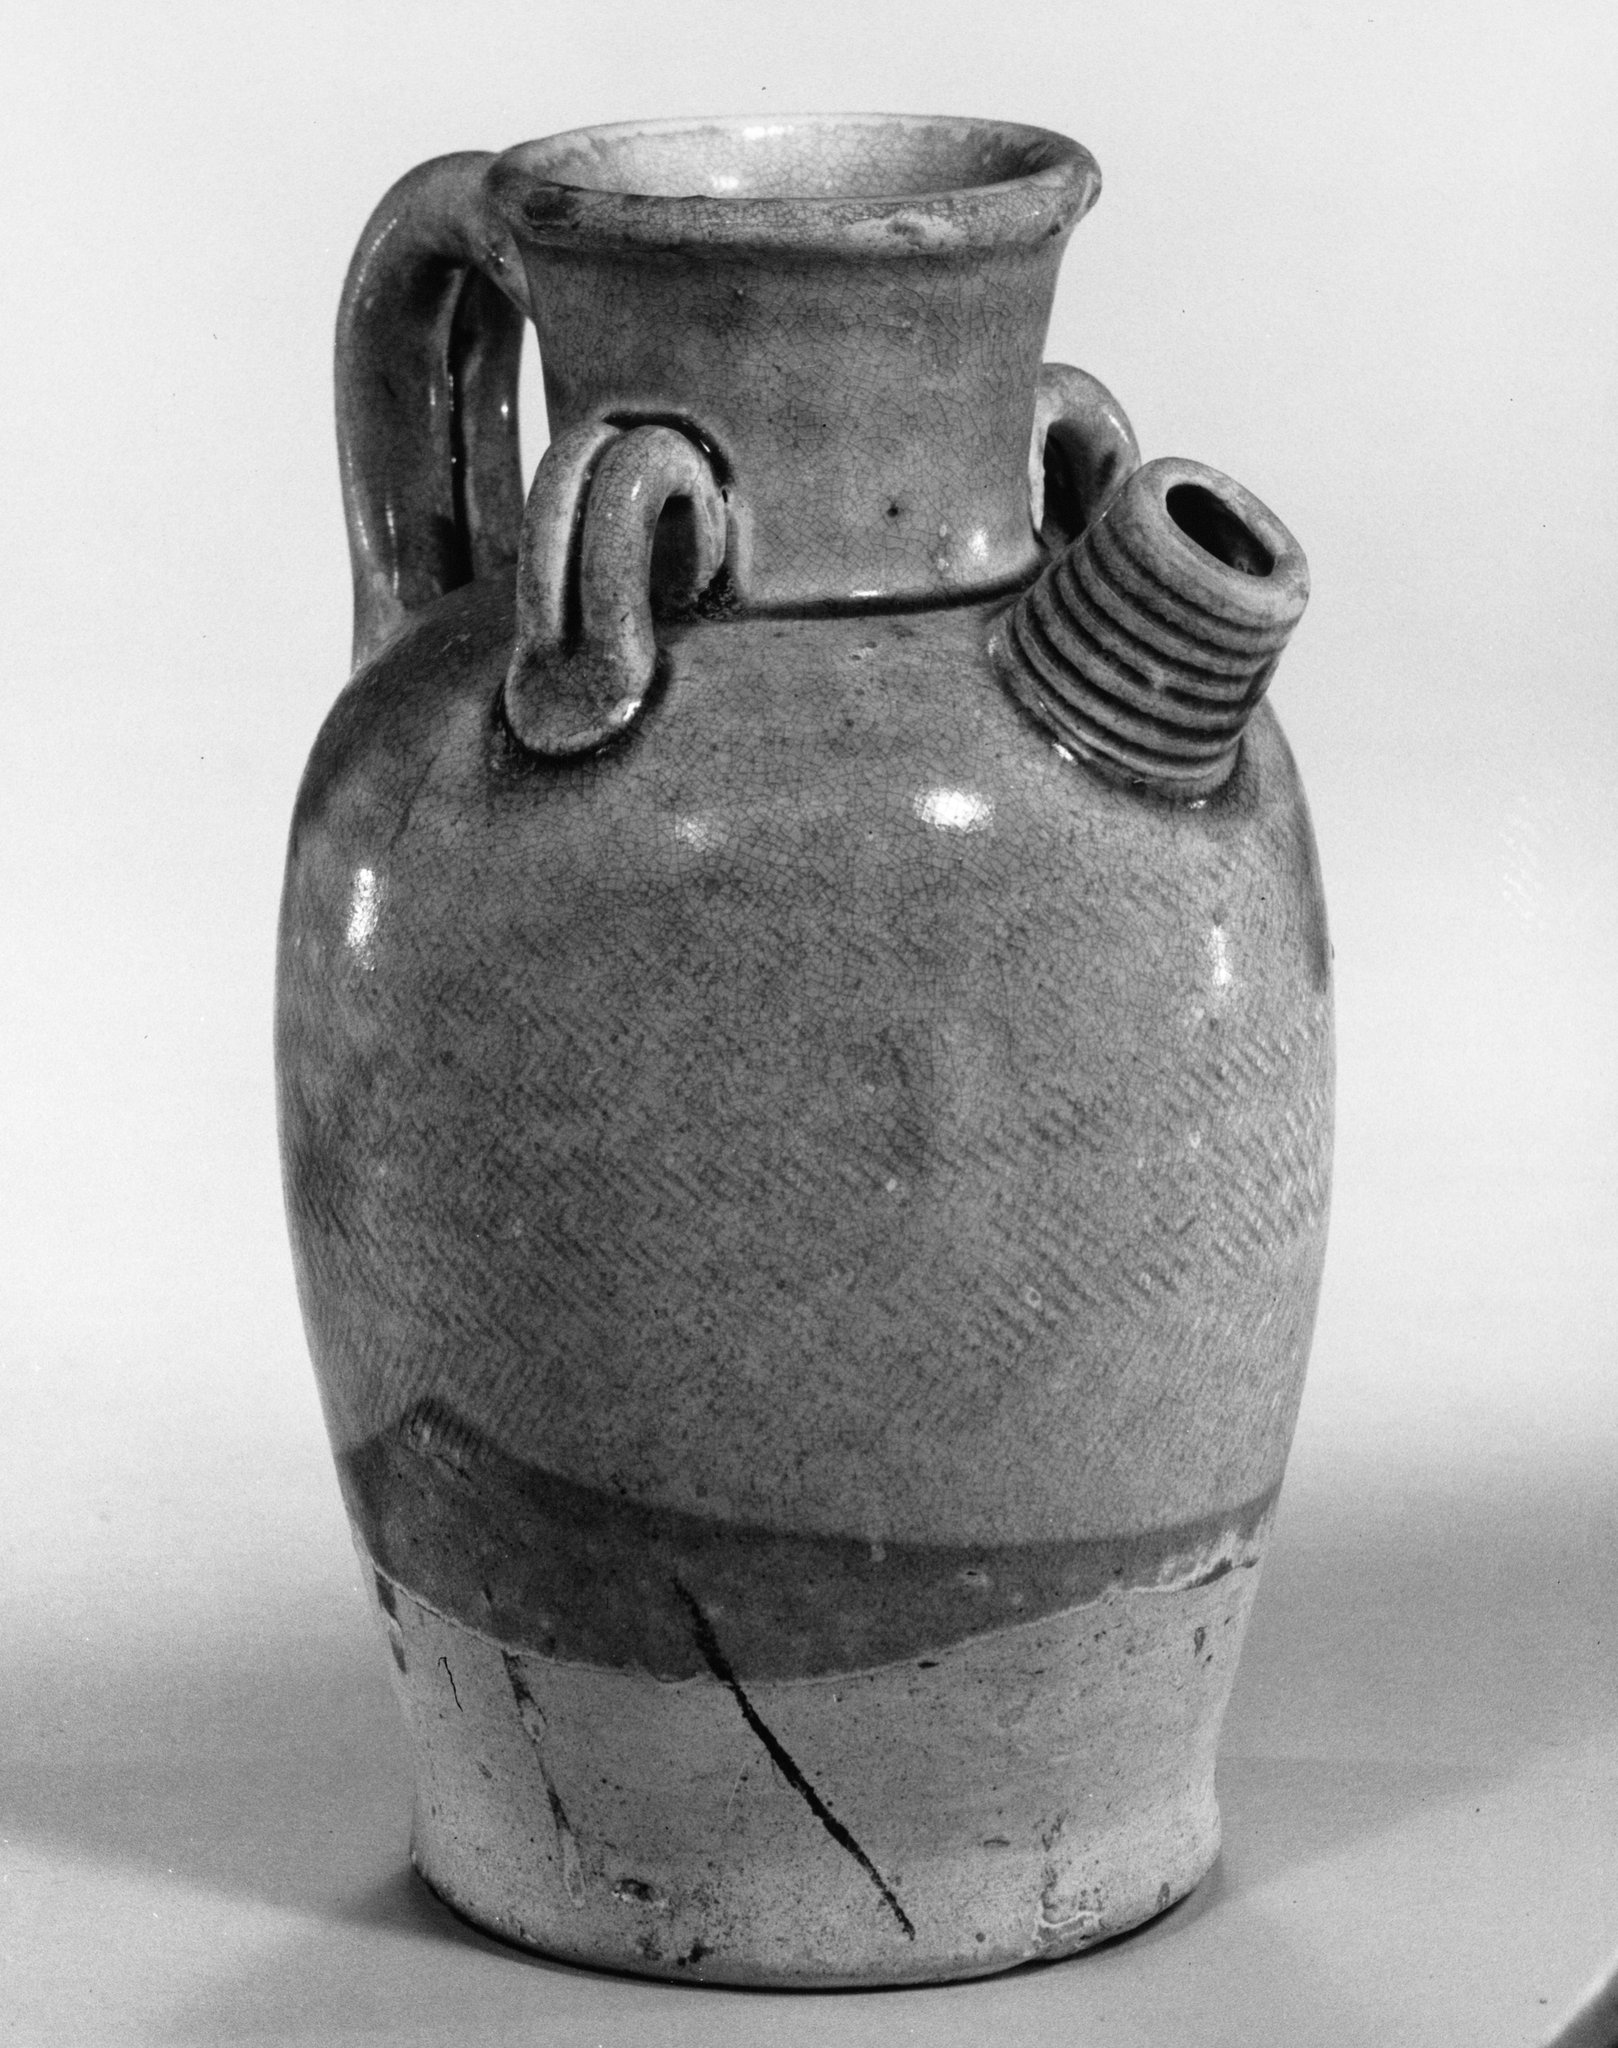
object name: ewer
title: Ewer with loop handles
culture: chinese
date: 801-900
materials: glaze, stoneware